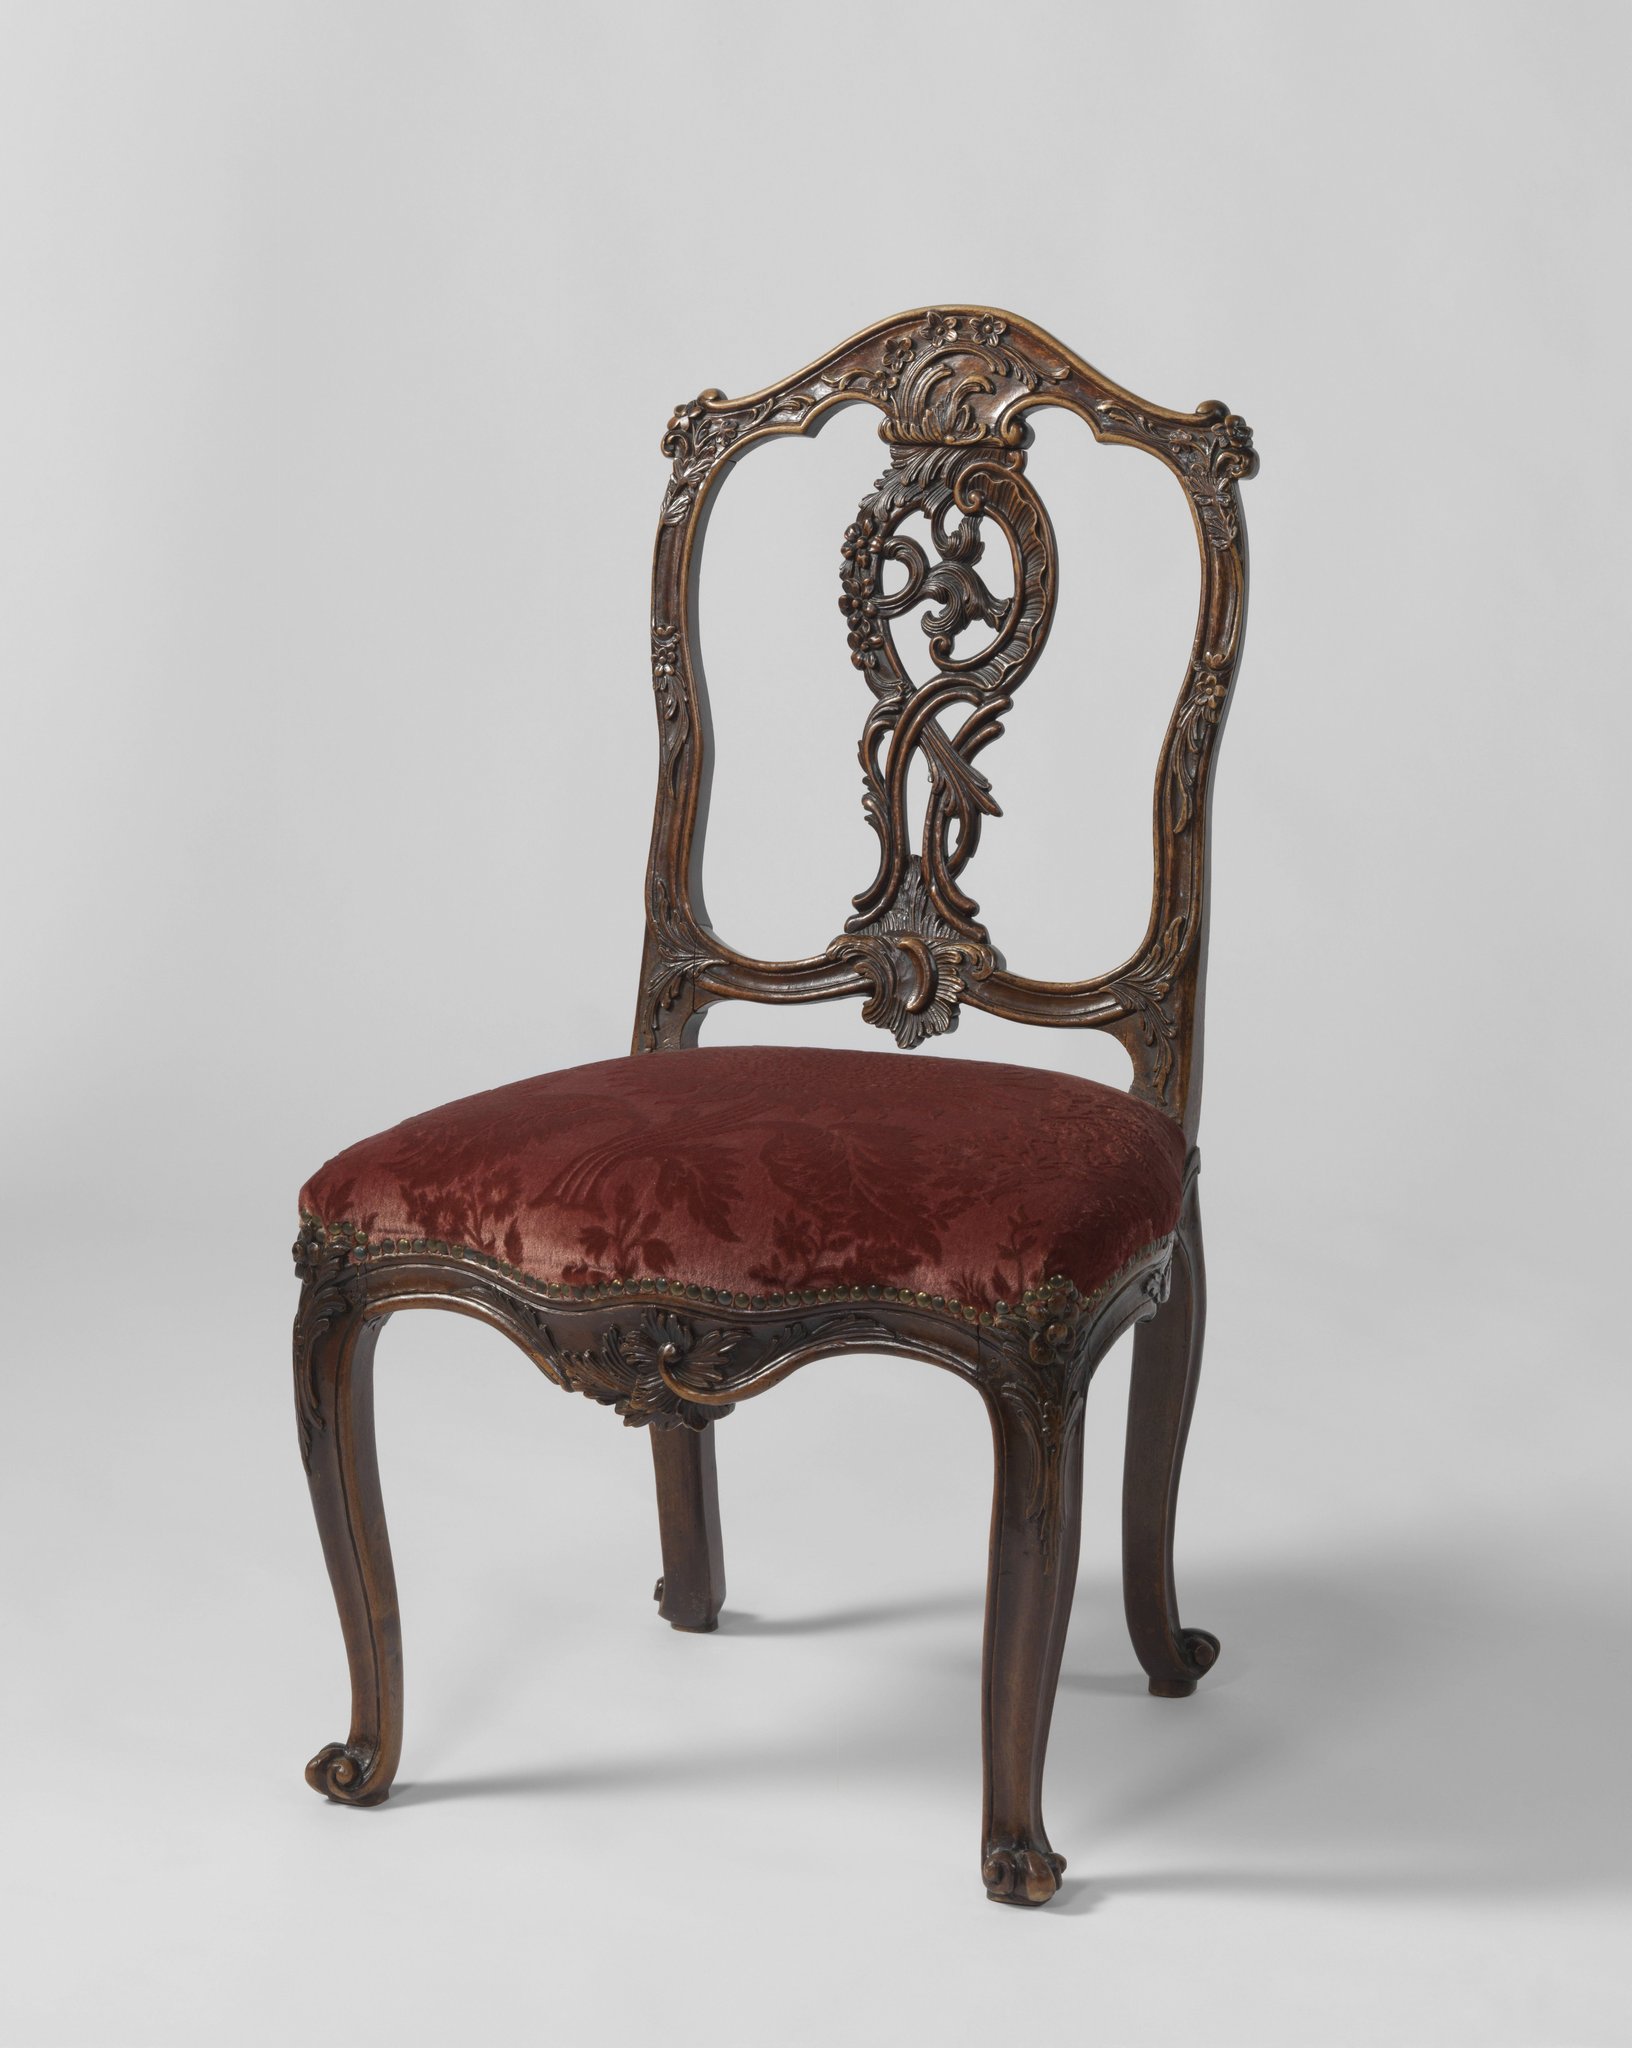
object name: chair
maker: jan ermans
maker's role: stoelenmaker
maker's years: 1702-1761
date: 1738-1739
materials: velvet, wood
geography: amsterdam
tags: rocaille ornament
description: This chair was supplied by the Amsterdam upholsterer Marinus Penninck in 1739 to the new town hall of Edam, located north of Amsterdam. He delivered a total of 46 chairs and 4 armchairs. They are the earliest known chairs made in the Netherlands in the Rococo style. The chairmaker Ermans was established in Amsterdam around 1737. The back was undoubtedly made by a sculptor.